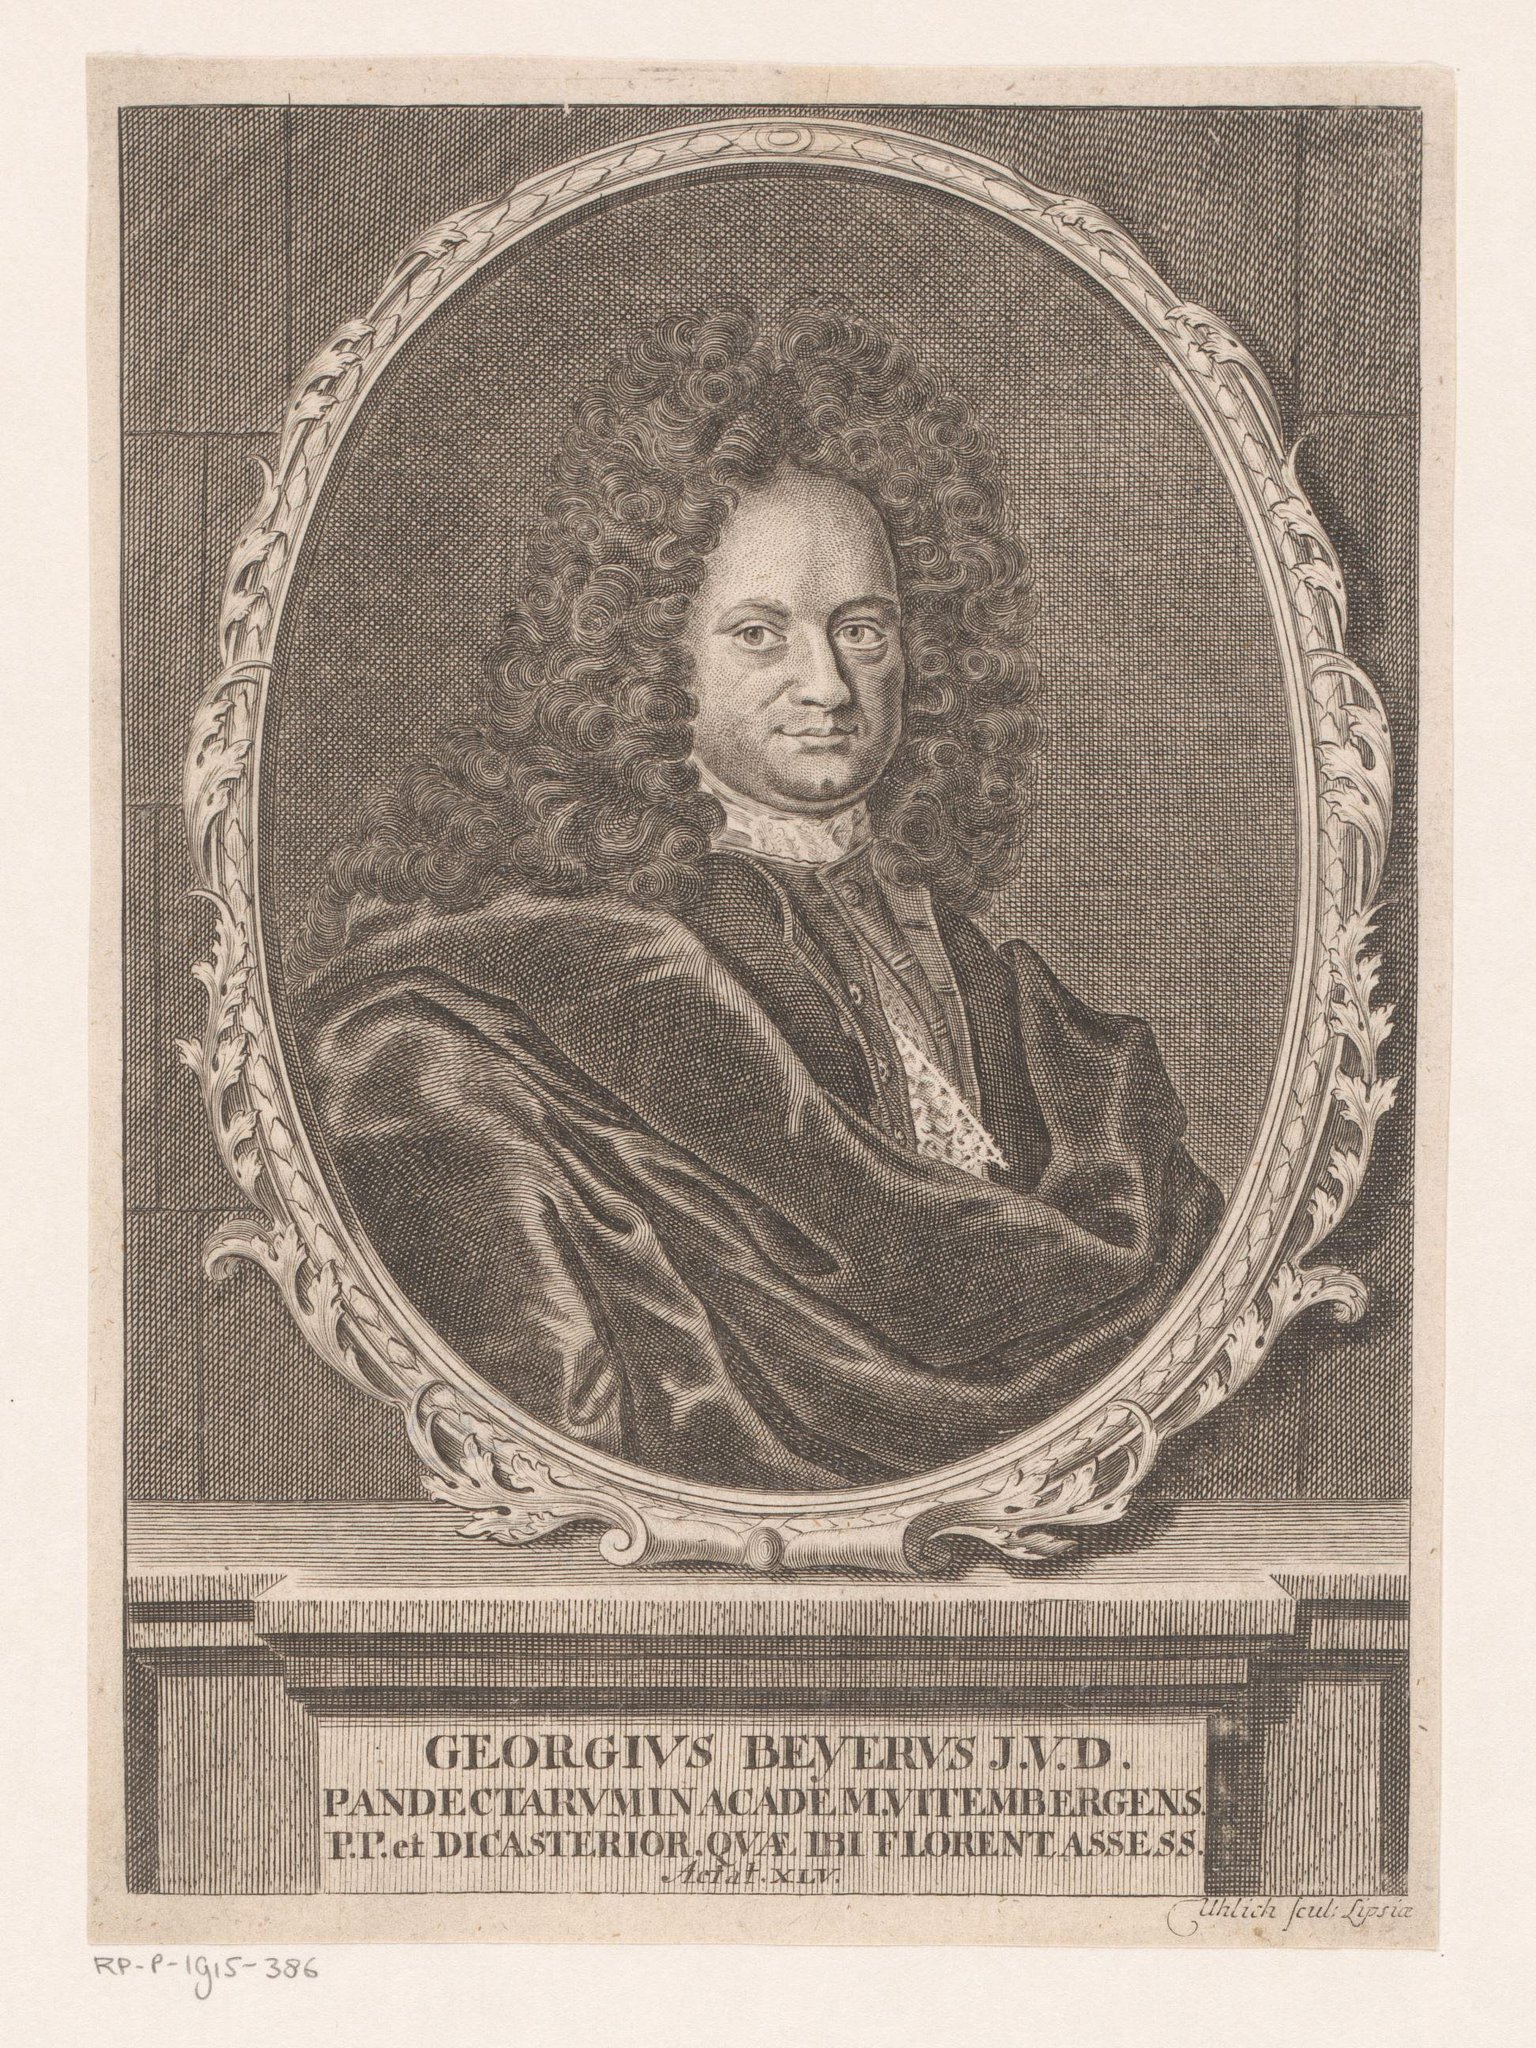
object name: print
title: Portret van Georg Beyer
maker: gabriel uhlich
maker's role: print maker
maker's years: 1682-1741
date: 1726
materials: paper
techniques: engraving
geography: leipzig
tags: berlin, georg beyer, historical persons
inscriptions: collector's mark: Lugt 2228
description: Prent gebruikt voor publicatie: Beyer, Georg. Delineatio Juris divini, naturalis et positivi naturalis. Leipzig: Johann Friedrich Braun, 1726.